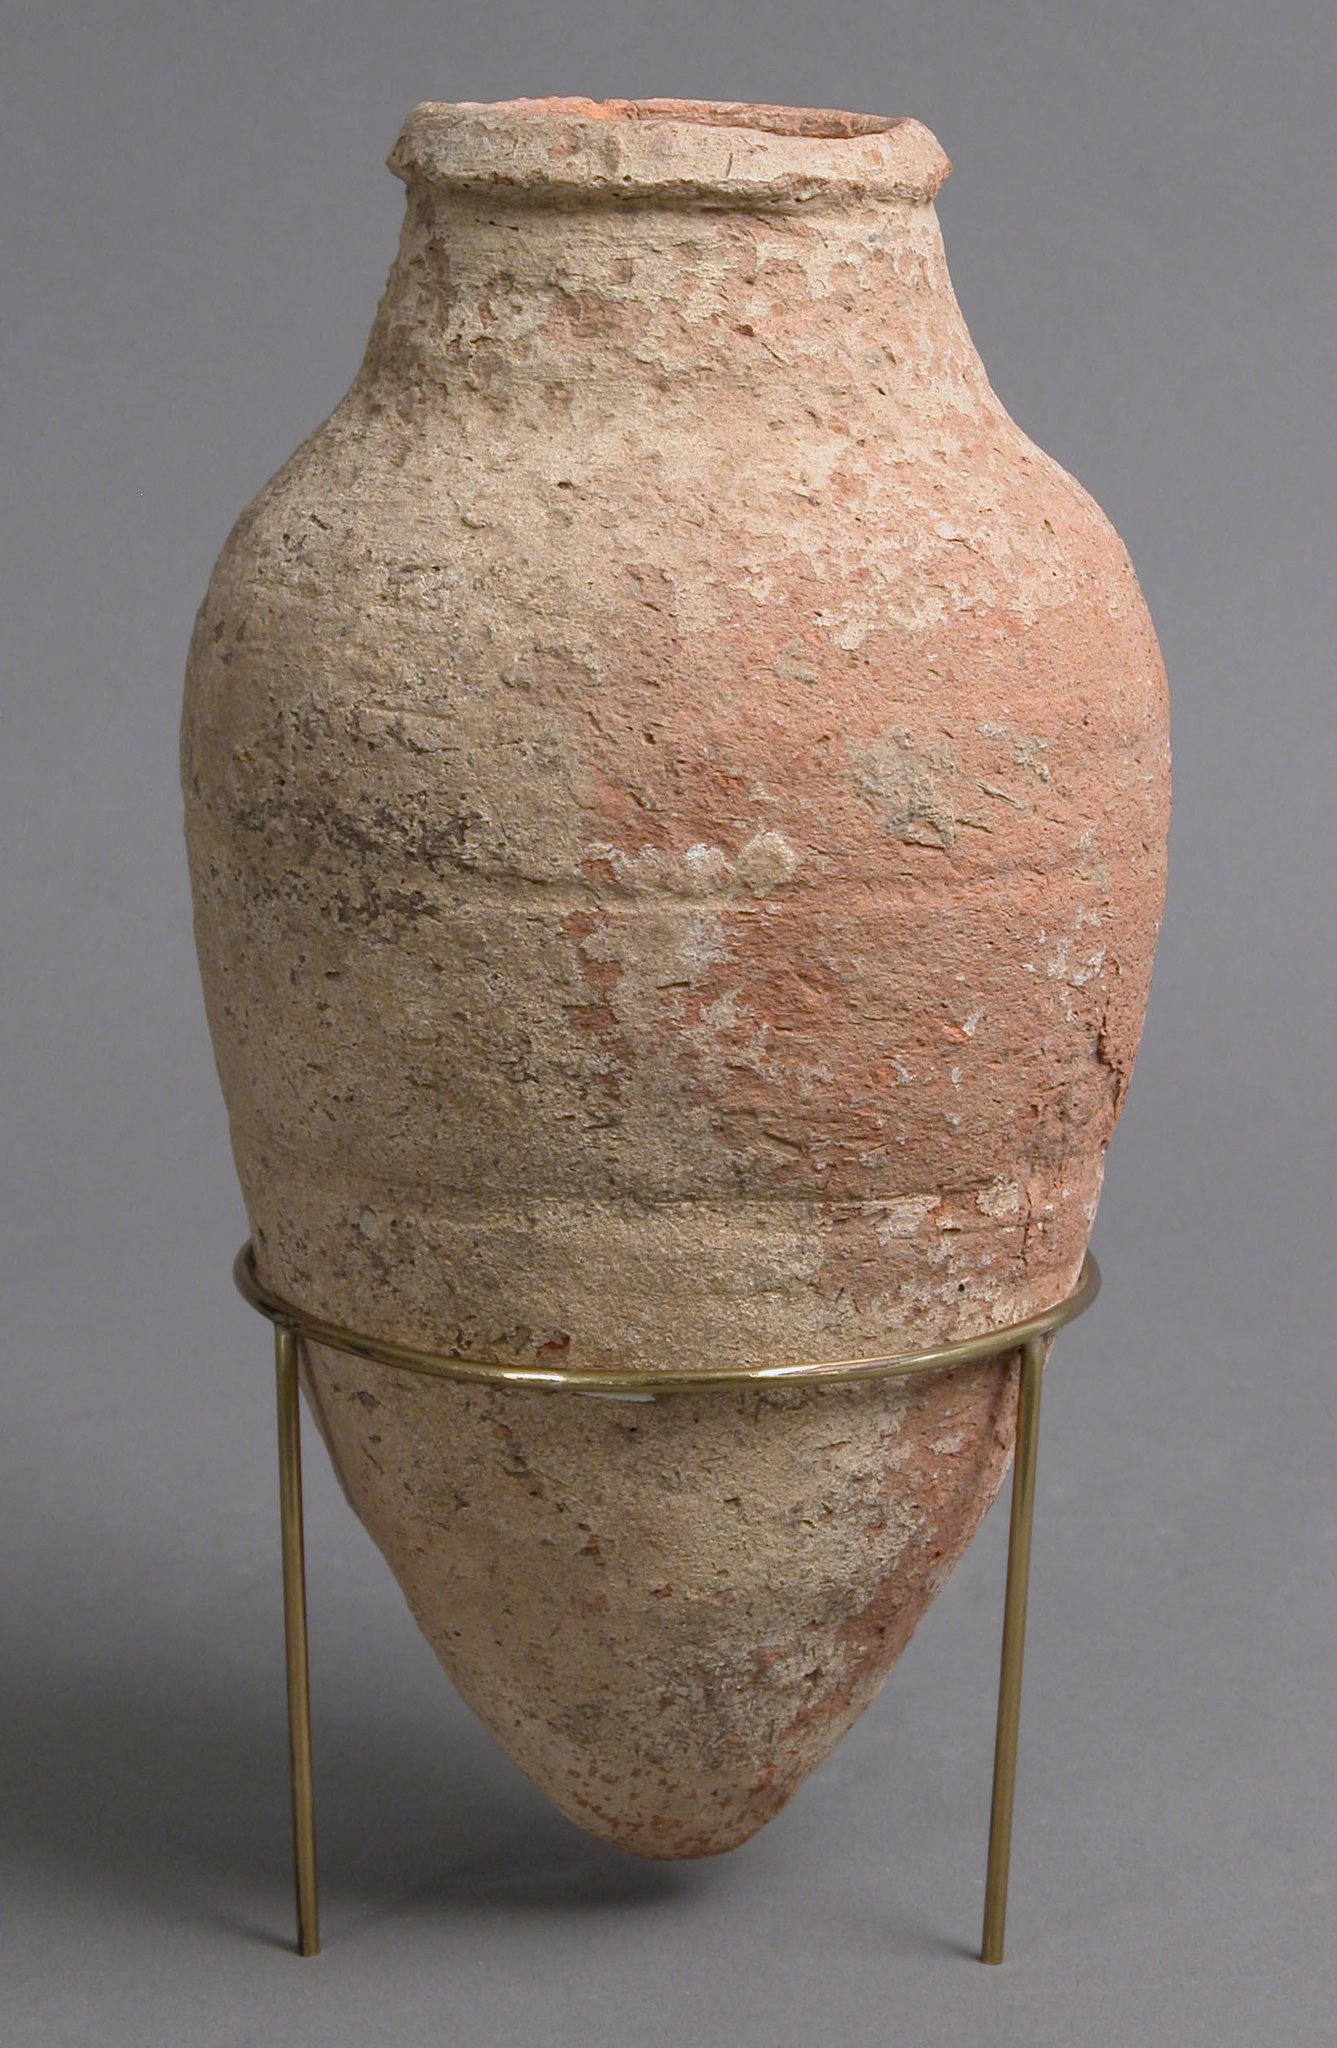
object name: amphora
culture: coptic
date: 301-700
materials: earthenware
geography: egypt